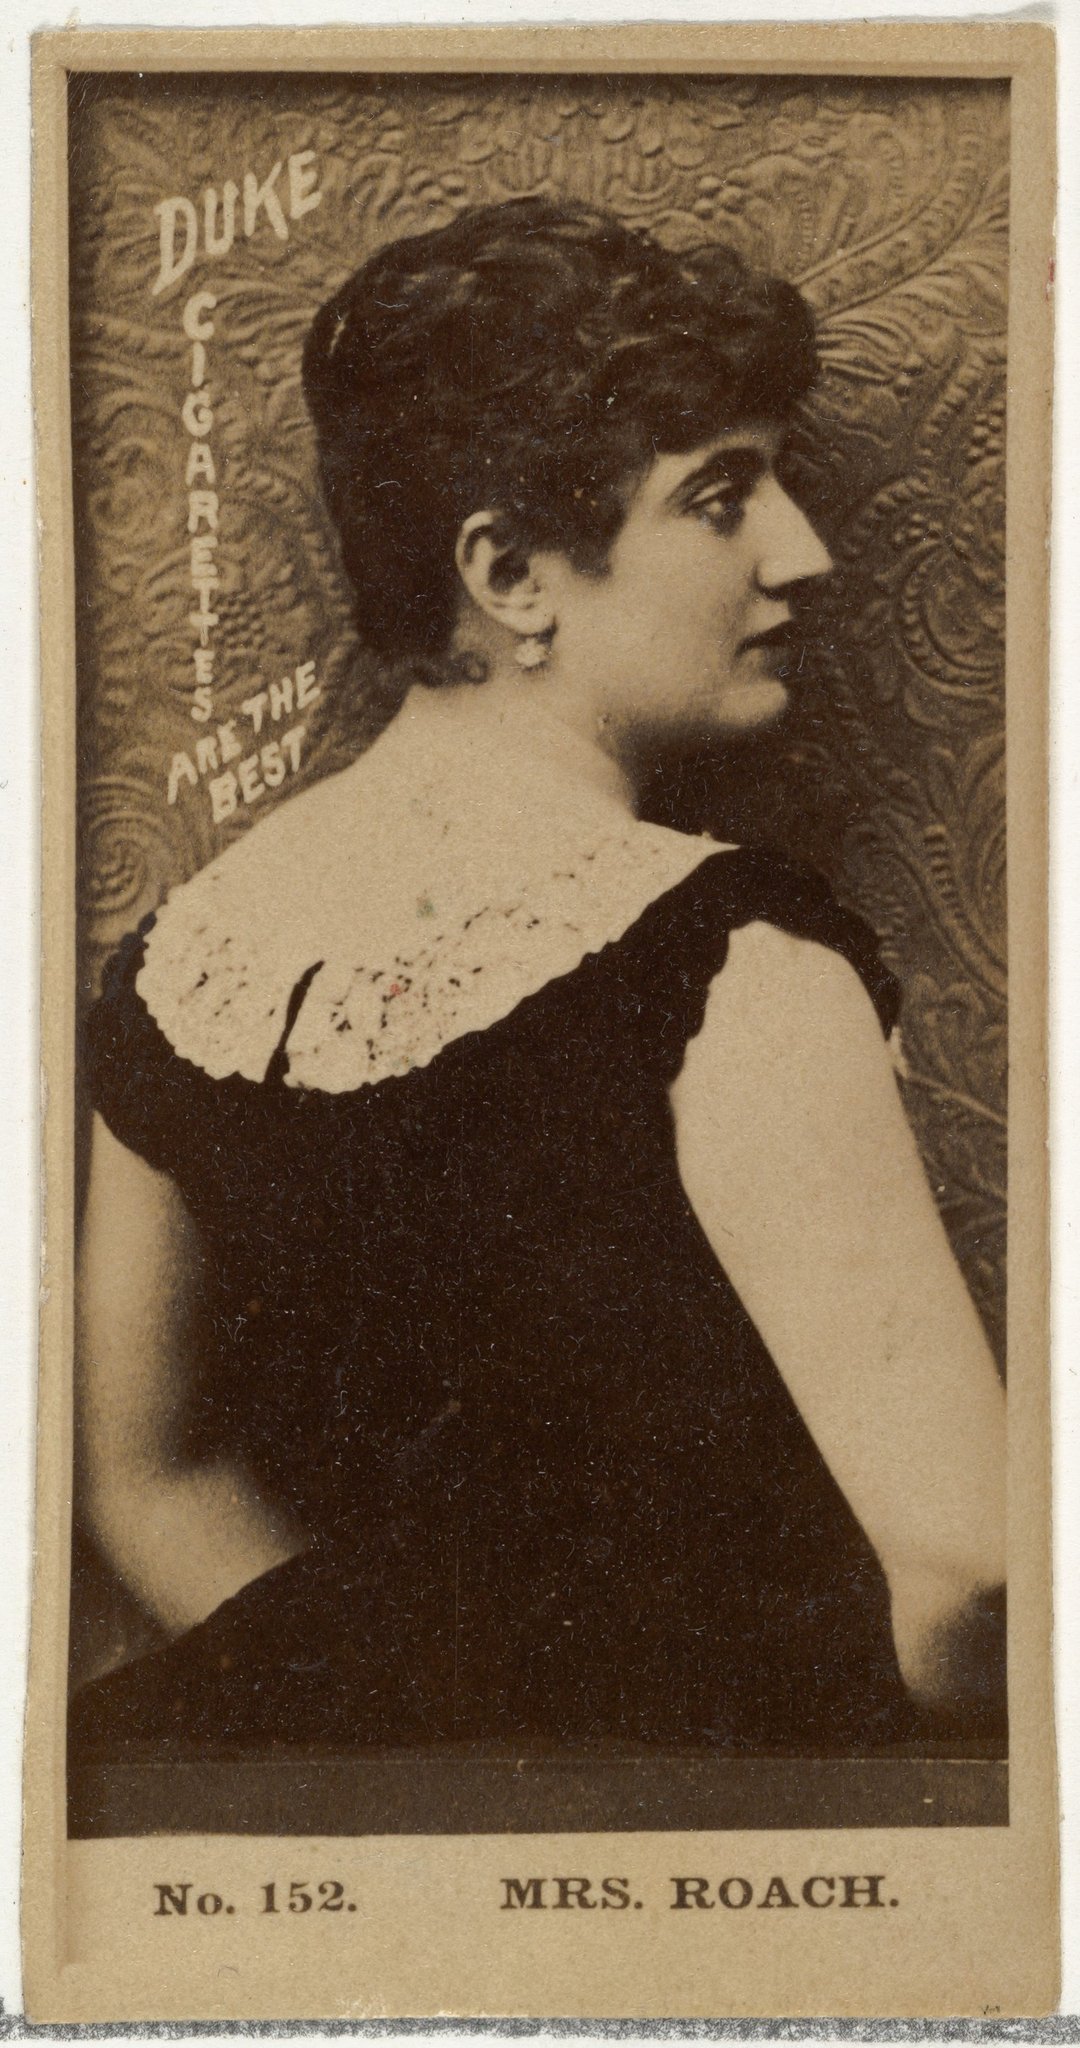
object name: photograph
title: Card Number 152, Mrs. Roach, from the Actors and Actresses series (N145-6) issued by Duke Sons & Co. to promote Duke Cigarettes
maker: w. duke, sons & co.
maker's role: publisher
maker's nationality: american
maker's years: 1870-1920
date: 1880-1889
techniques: albumen silver print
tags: women,actresses